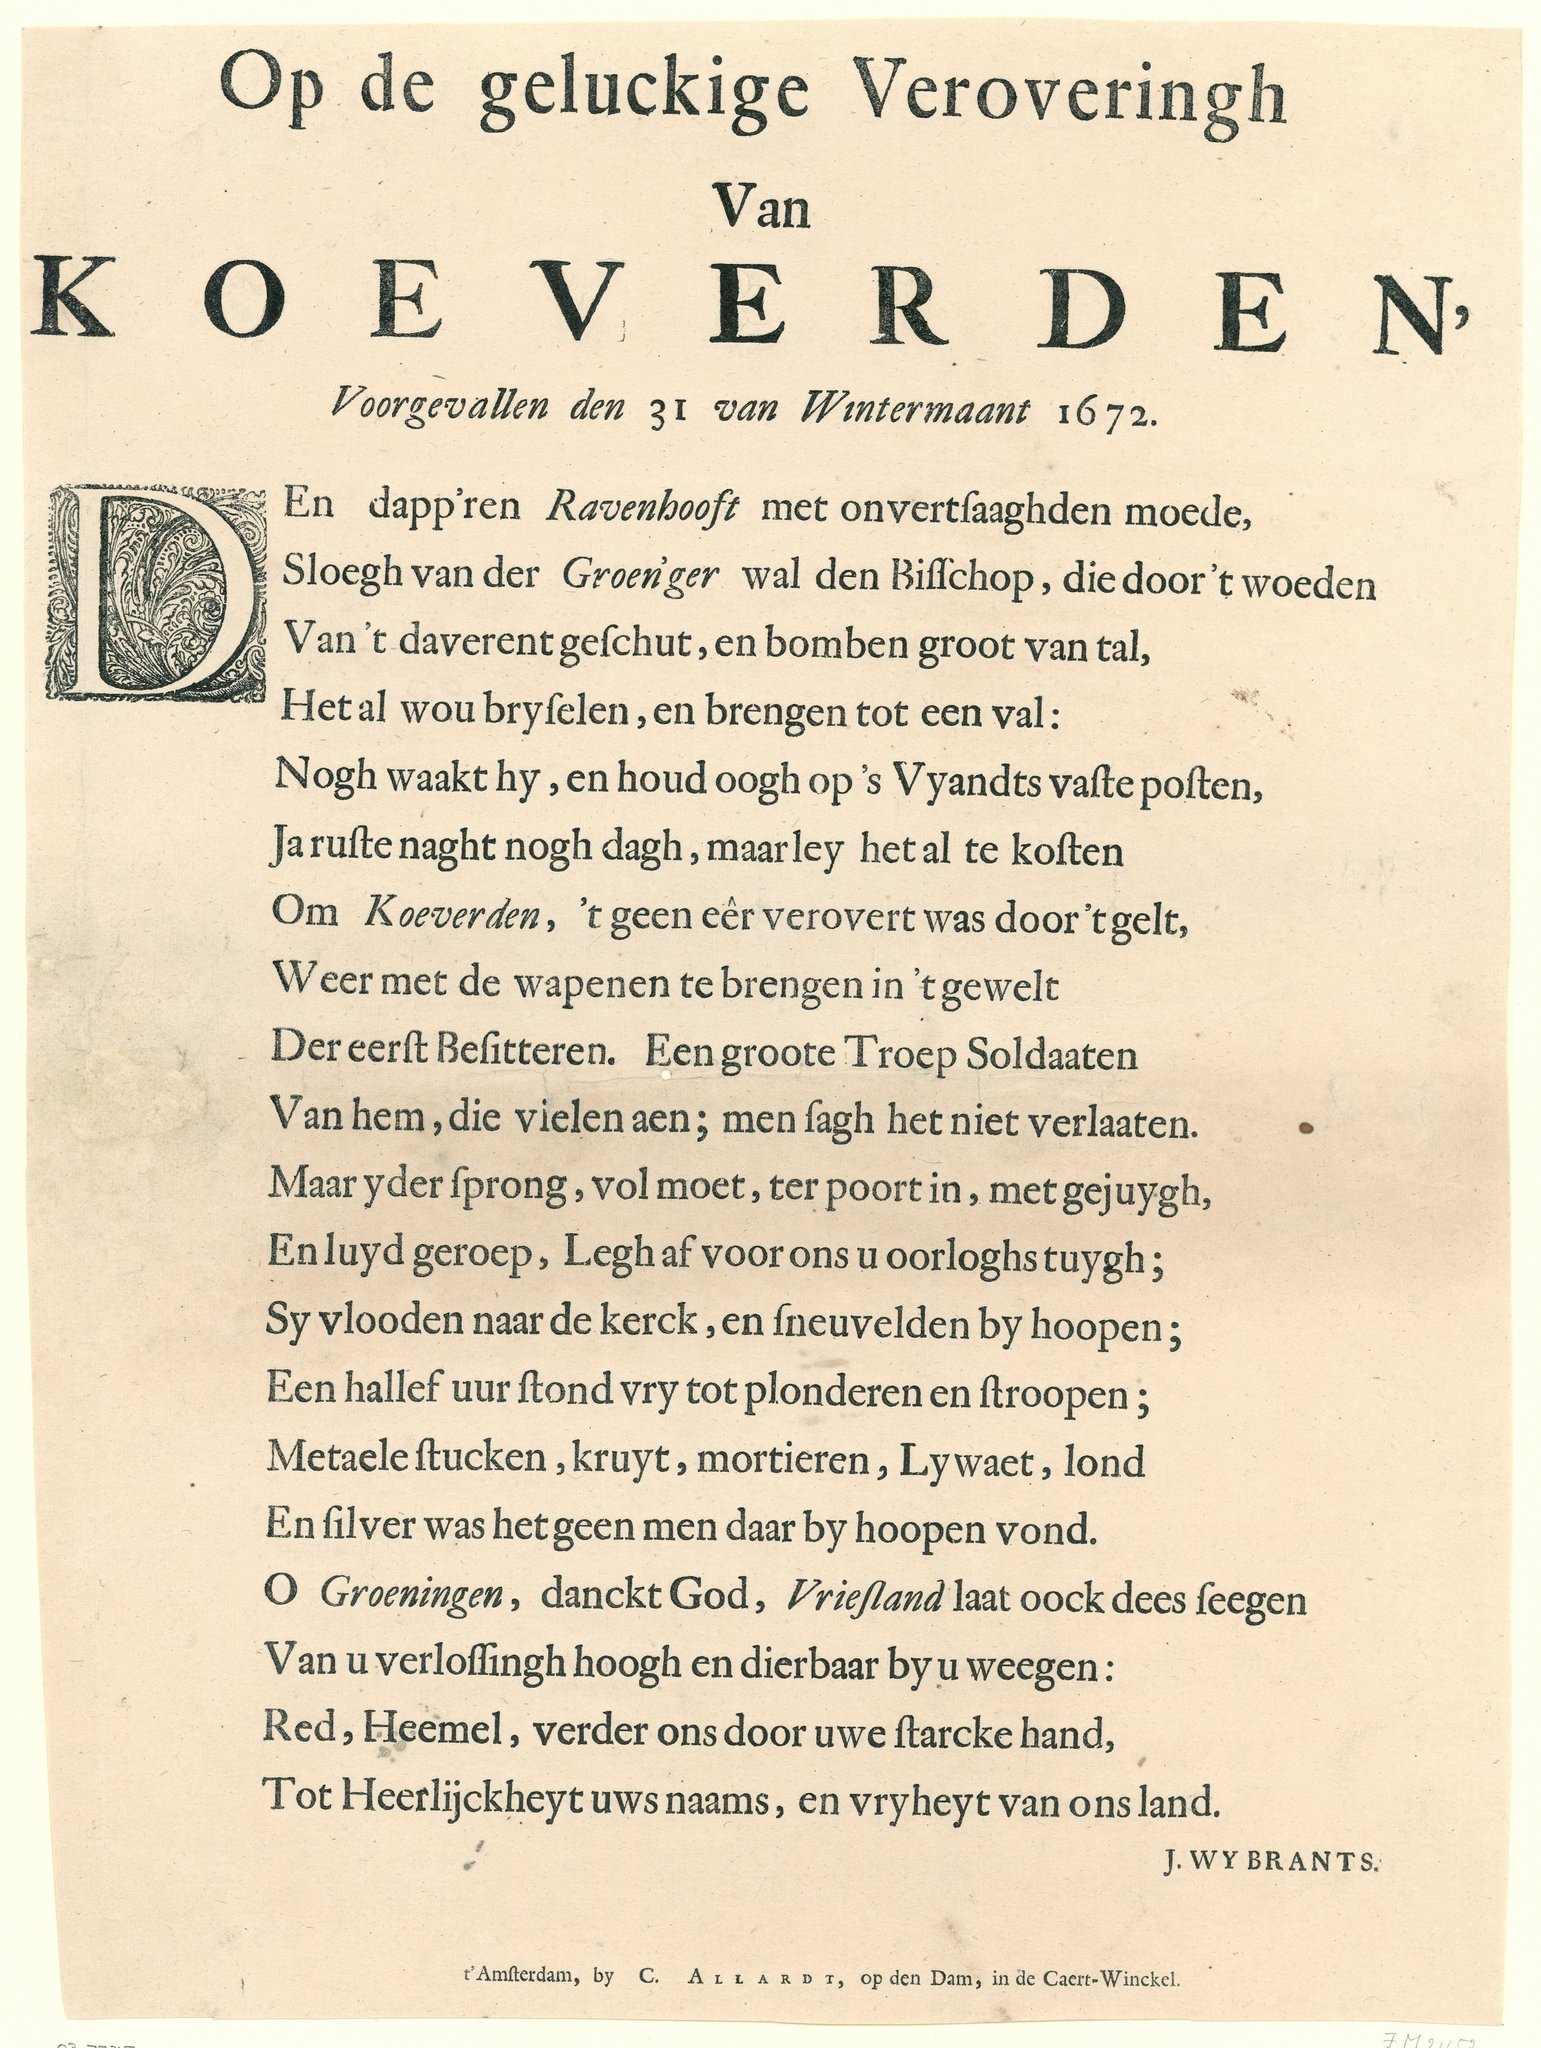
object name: text sheet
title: Vers op de verovering van Coevorden op 30 december 1672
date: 1672-1673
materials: paper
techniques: letterpress printing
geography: northern netherlands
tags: bohemen, karl rabenhaupt (baron von sucha), coevorden, verovering van coevorden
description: Blad met een vers van twintig regels op de verovering van Coevorden op 30 december 1672 door de troepen onder leiding van Karl Rabenhaupt op de troepen van de bisschop van Munster. Het vers is gesigneerd door J. Wybrants